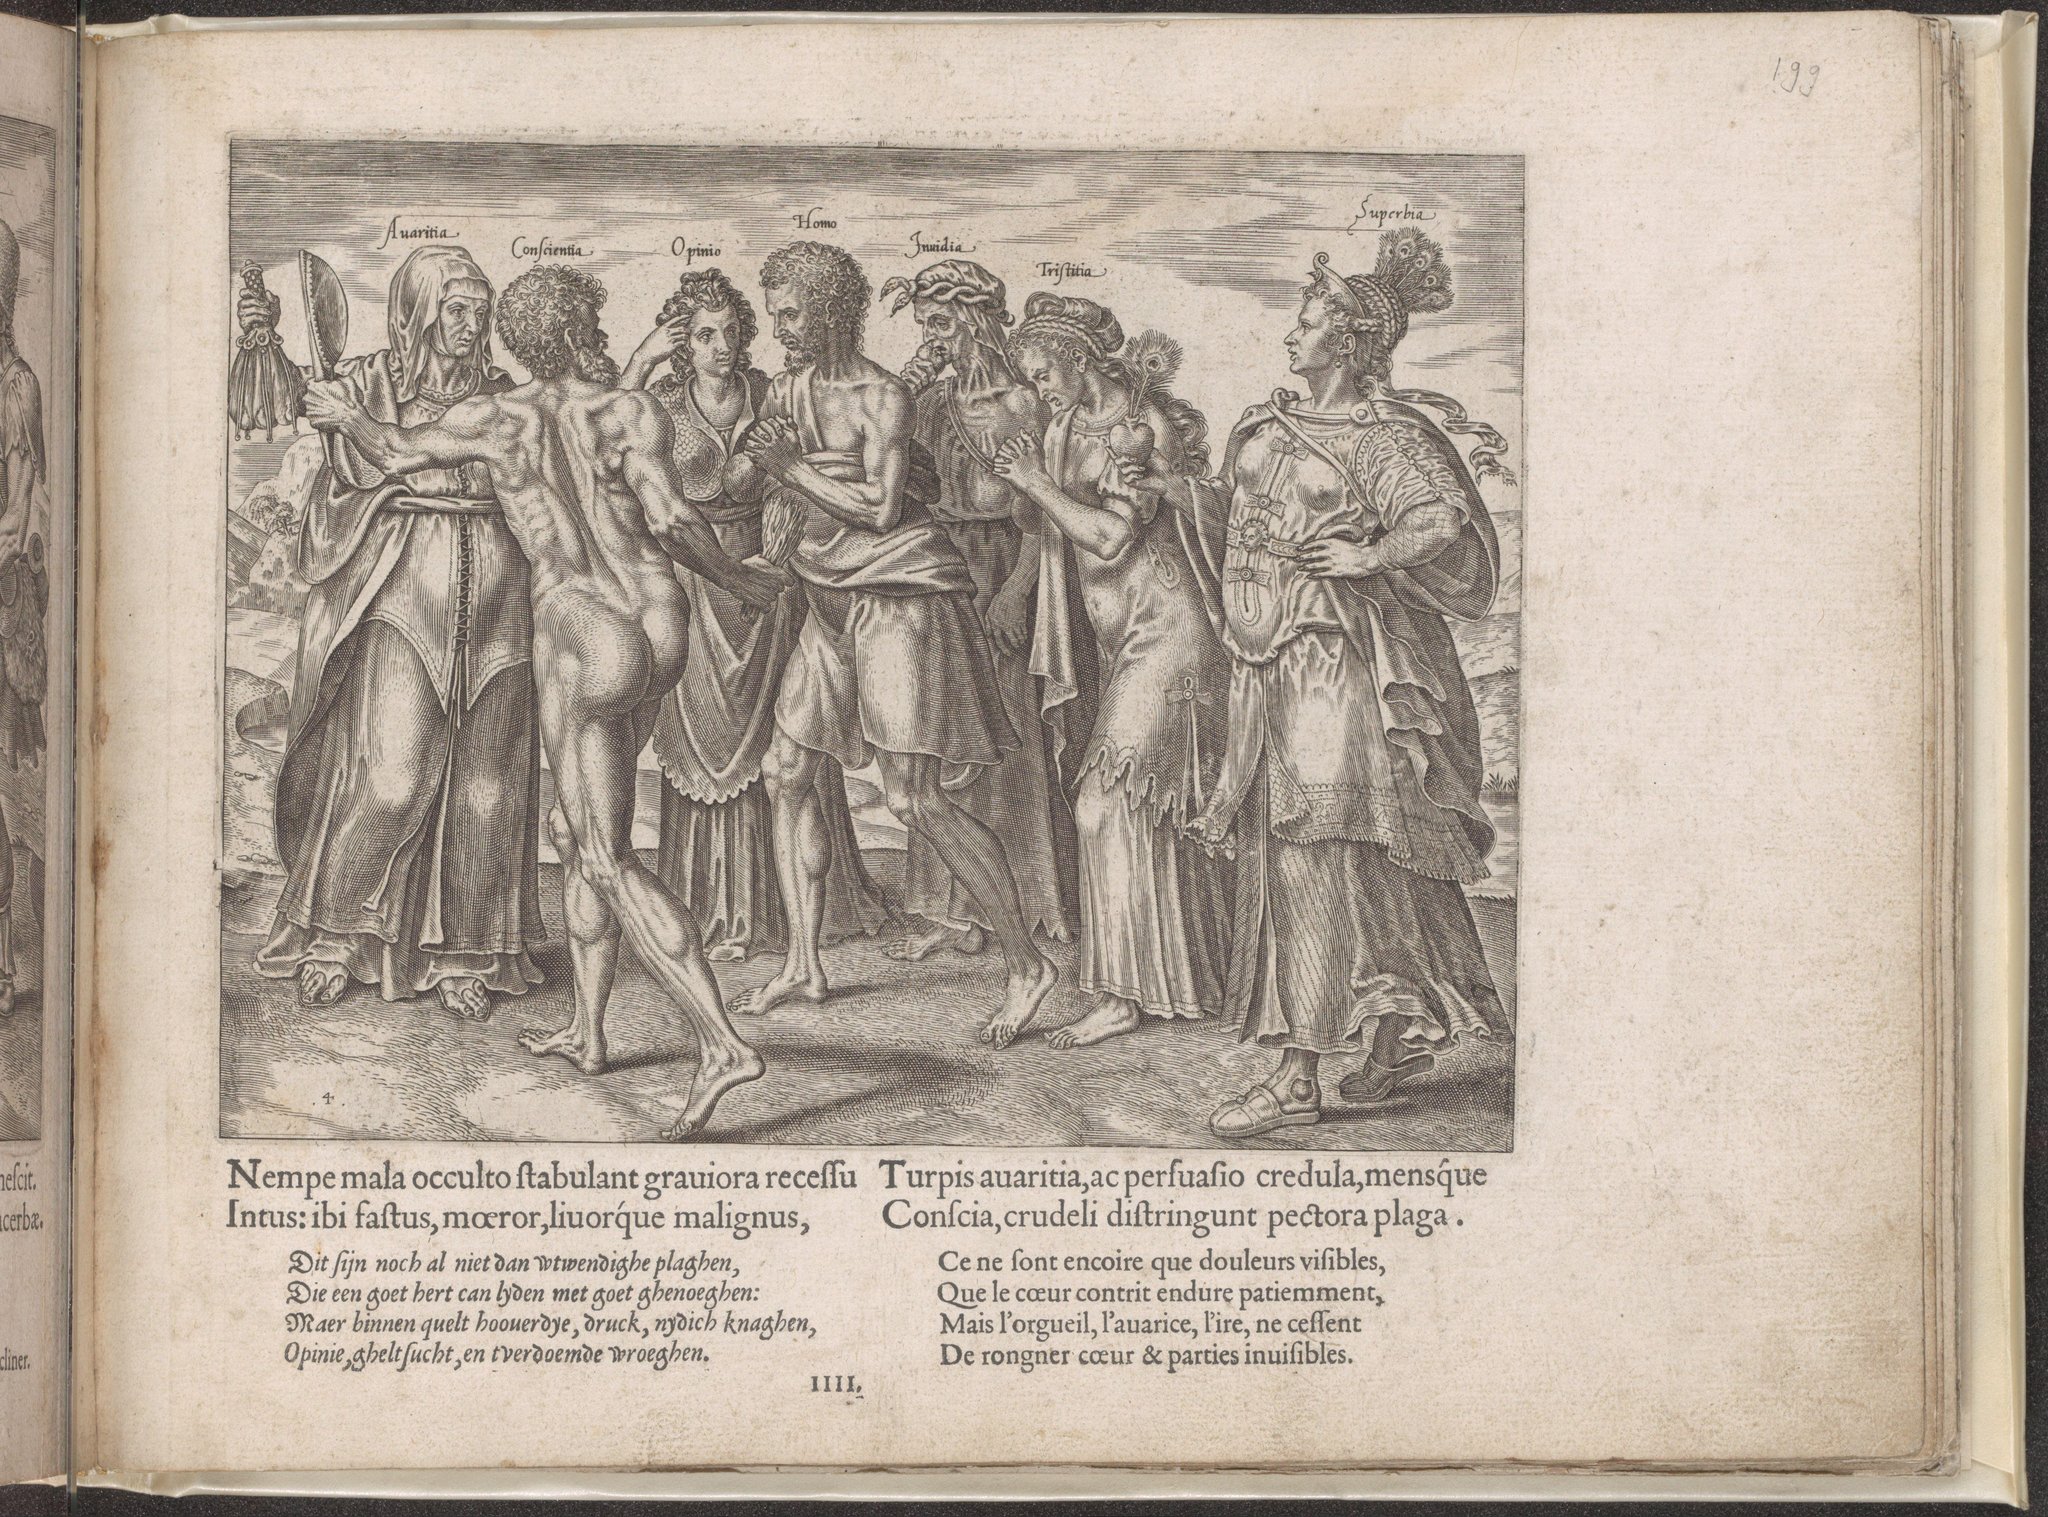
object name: album leaf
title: Ellende van het menselijk bestaan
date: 1563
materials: paper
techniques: engraving, letterpress printing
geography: haarlem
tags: envy; 'invidia' (ripa) ~ personification of one of the seven deadly sins, pride; 'superbia' (ripa) ~ personification of one of the seven deadly sins, covetousness; 'avaritia' (ripa) ~ personification of one of the seven deadly sins, conscience; 'coscienza' (ripa), pain, sorrow, sadness; 'dolore', 'dolore di zeusi' (ripa), public opinion; 'opinione' (ripa)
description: De mens (Homo) wordt door allerlei zonden belaagd: de personificaties van Hebzucht (Avarita), Verkeerde Mening (Opnio), Nijd (Invidia), Droefheid (Tristitia) en Hoogmoed (Superbia). Het personage Geweten (Conscientia) probeert de mens op het goede pad te leiden door middel van een spiegel (inzicht) en een roede (straf). Onder de voorstelling een vers in het Latijn en een Nederlands en Frans onderschrift in boekdruk. Deze prent maakt deel uit van een album.